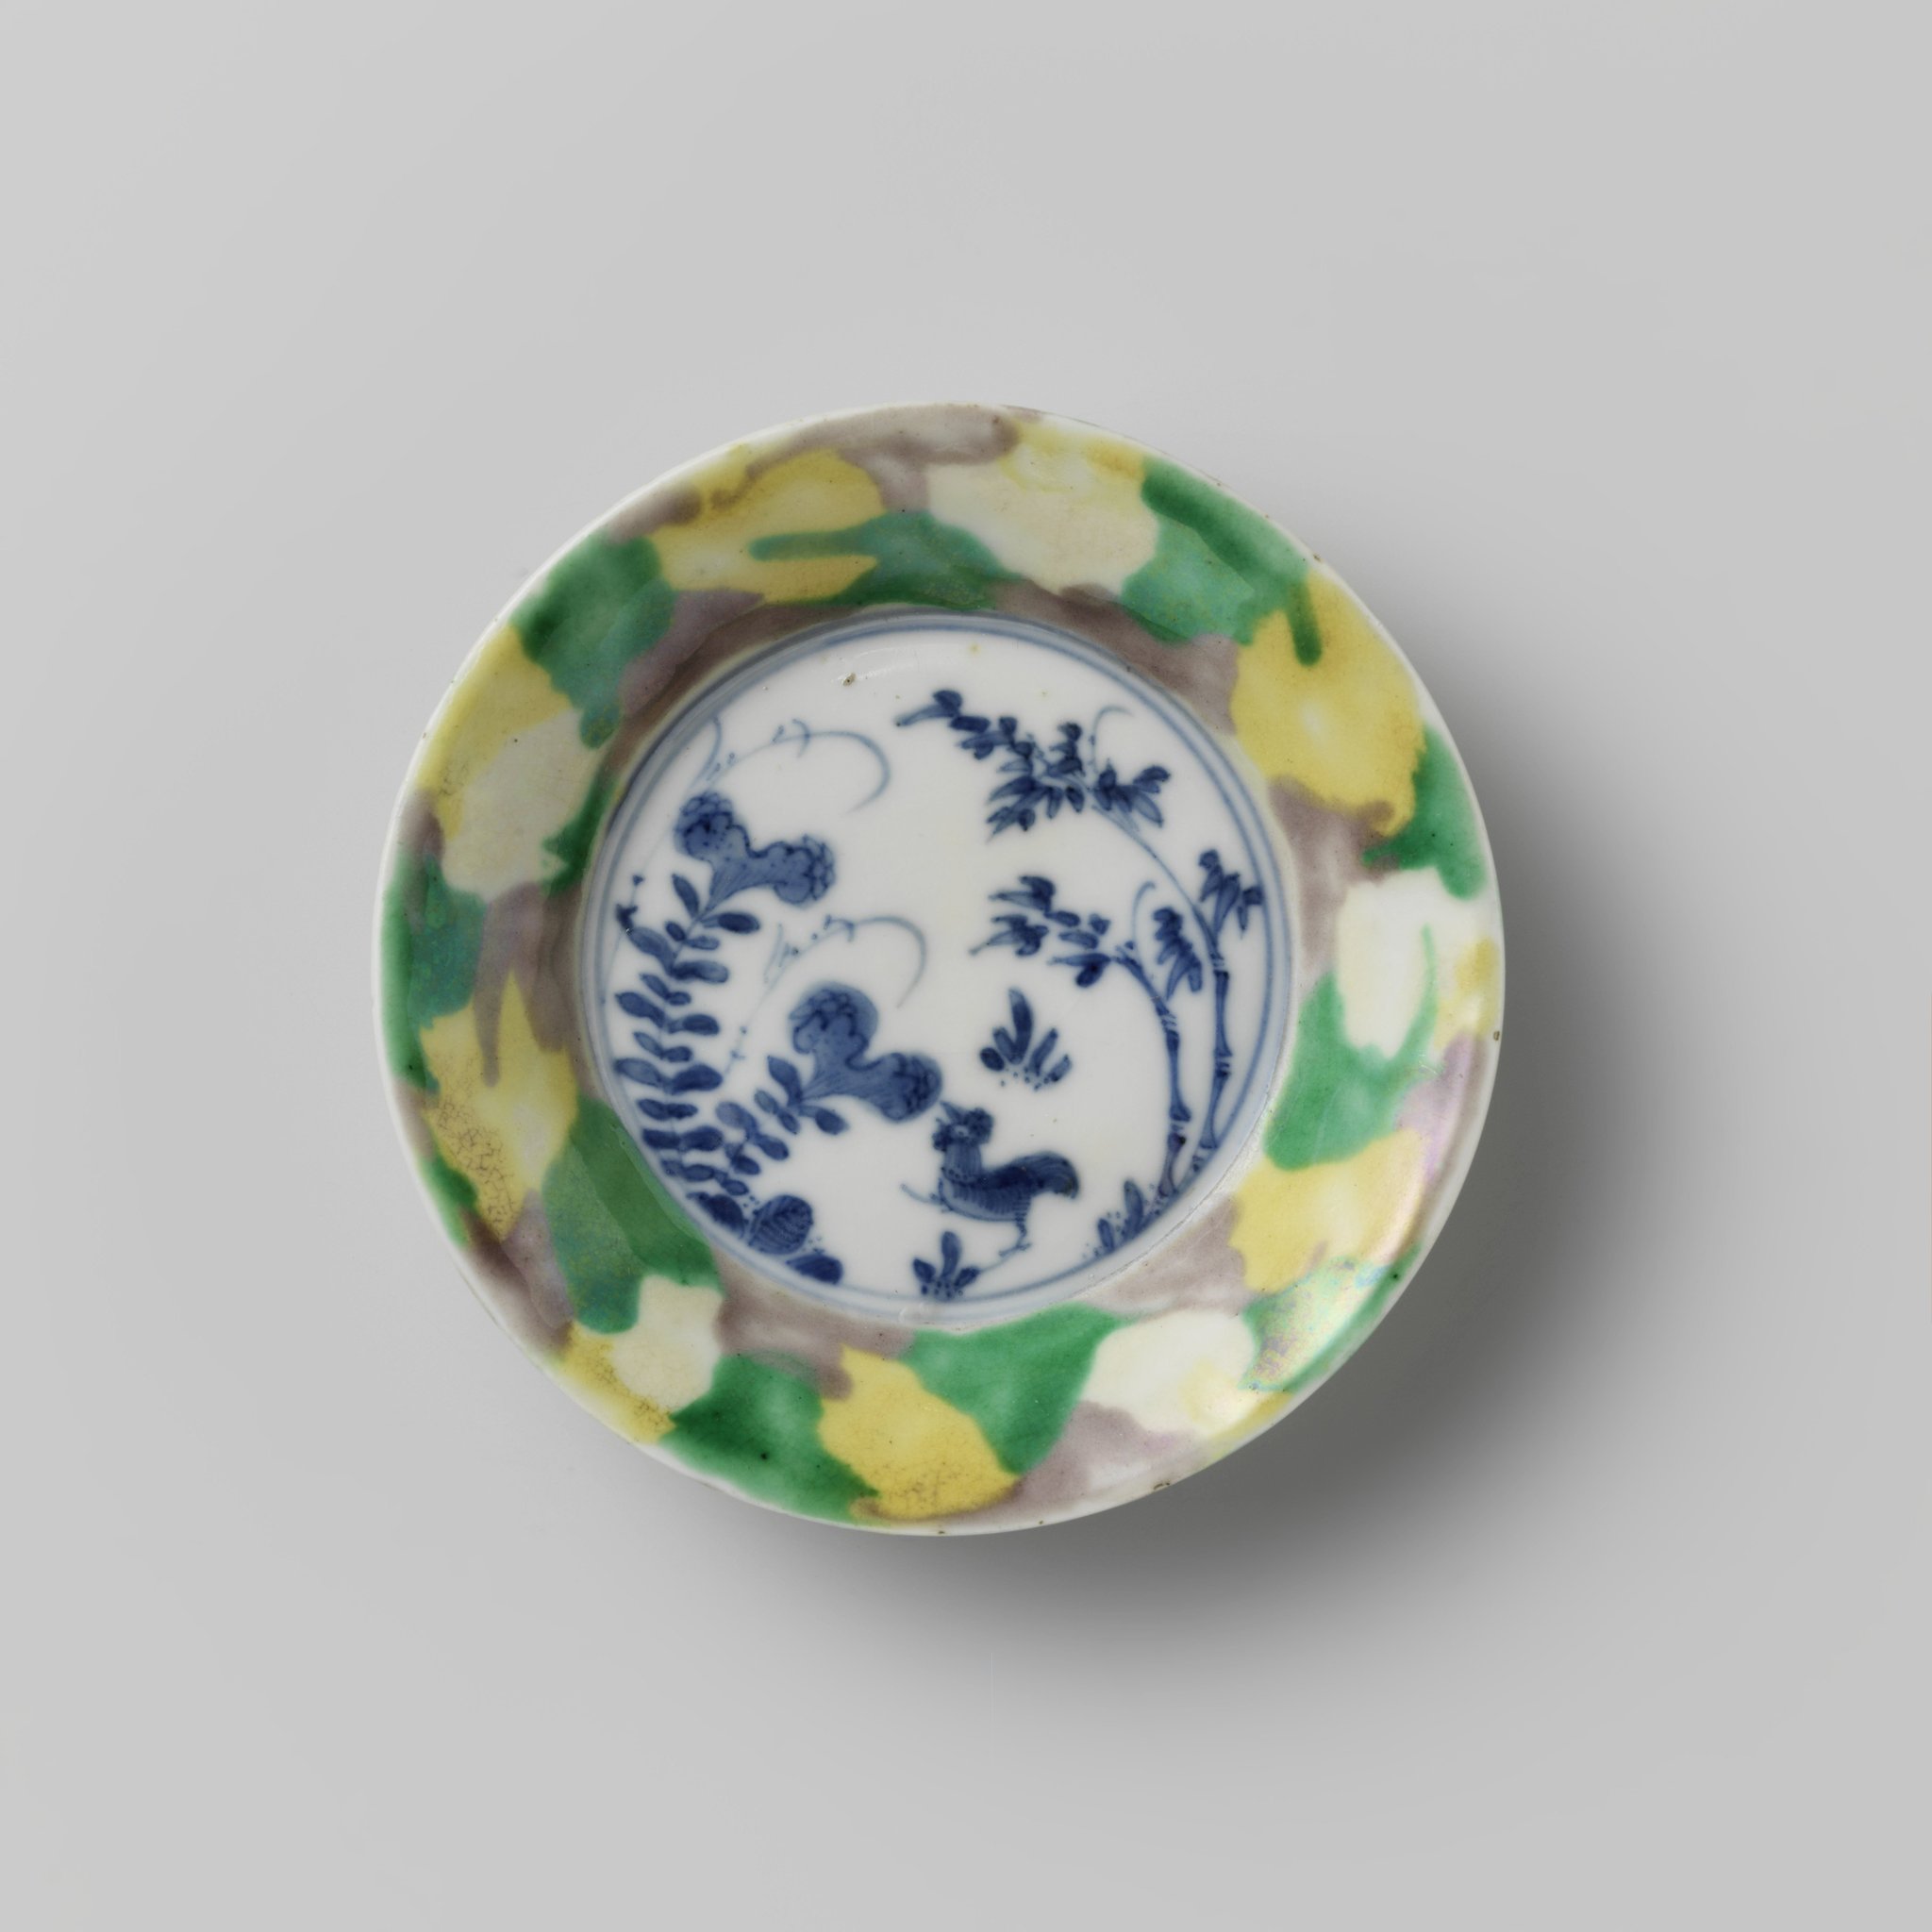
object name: platter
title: Saucer with 'egg and spinach' pattern and cock among plants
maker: Anonymous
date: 1700-1720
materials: cobalt, glaze, paint, porcelain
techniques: firing, turning, vitrification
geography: china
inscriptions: mark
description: Diepe schotel van porselein, beschilderd in onderglazuur blauw en op het glazuur groen, geel en aubergine. Op het plat een haan naast bamboe en een bloeiende plant; de wand aan binnen- en buitenzijde bedekt met een 'egg and spinach' patroon. Gemerkt op de onderzijde met een paddenstoel (lingzhi). Famille verte.